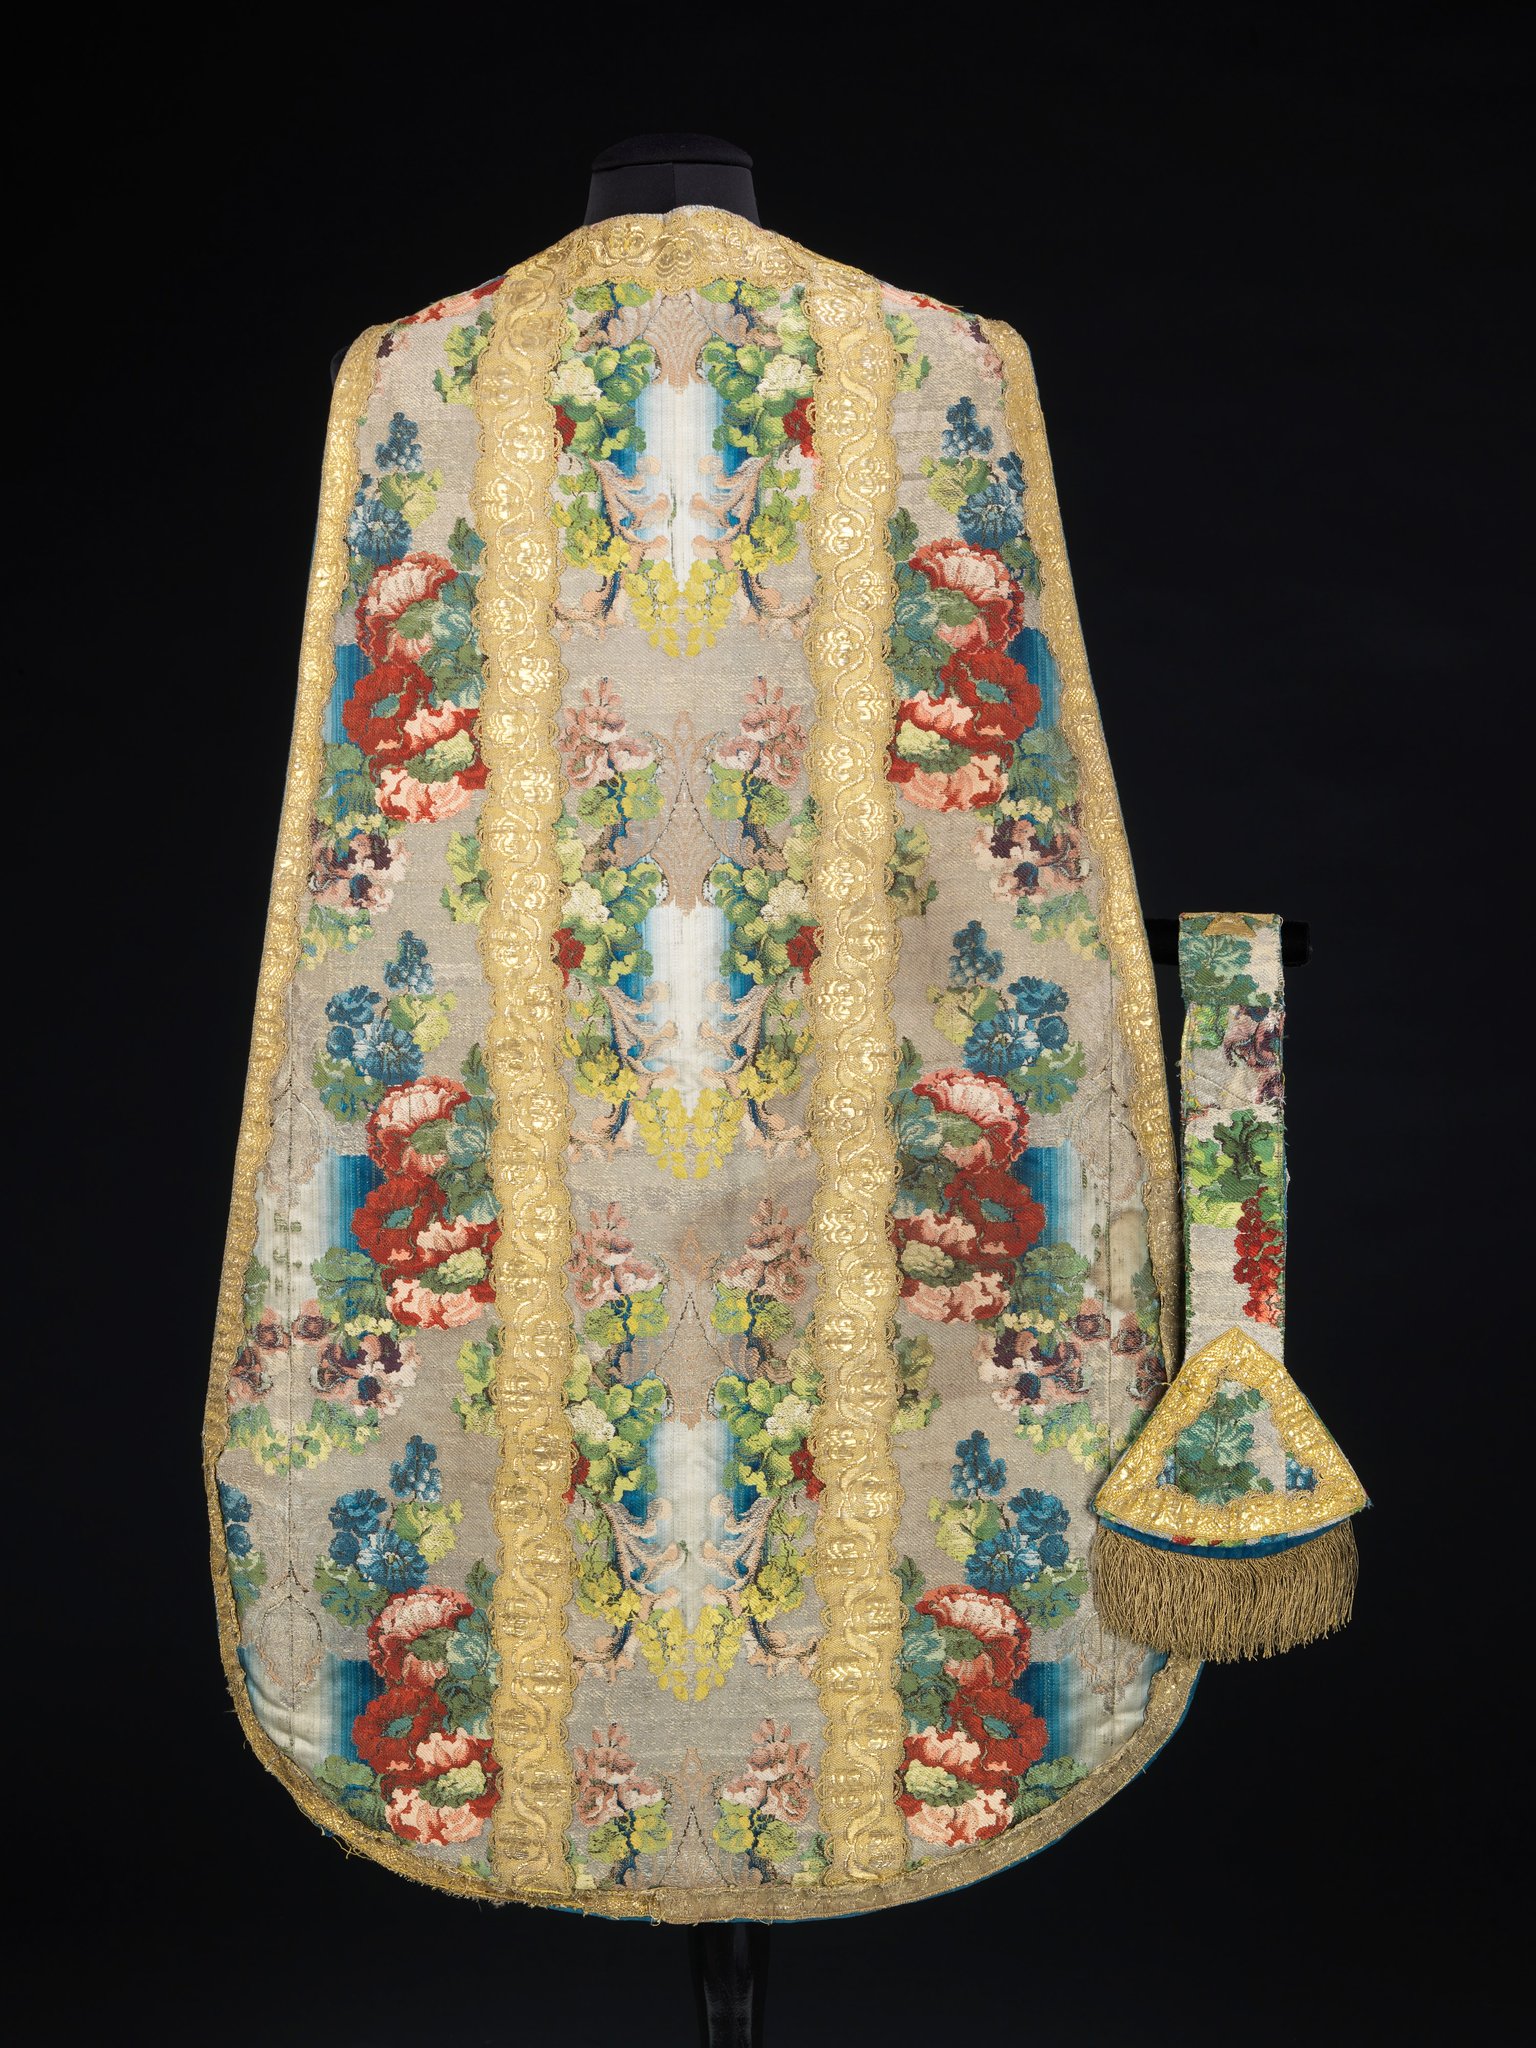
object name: vestment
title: Chasuble and maniple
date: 1726-1750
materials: metal, silk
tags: flowers